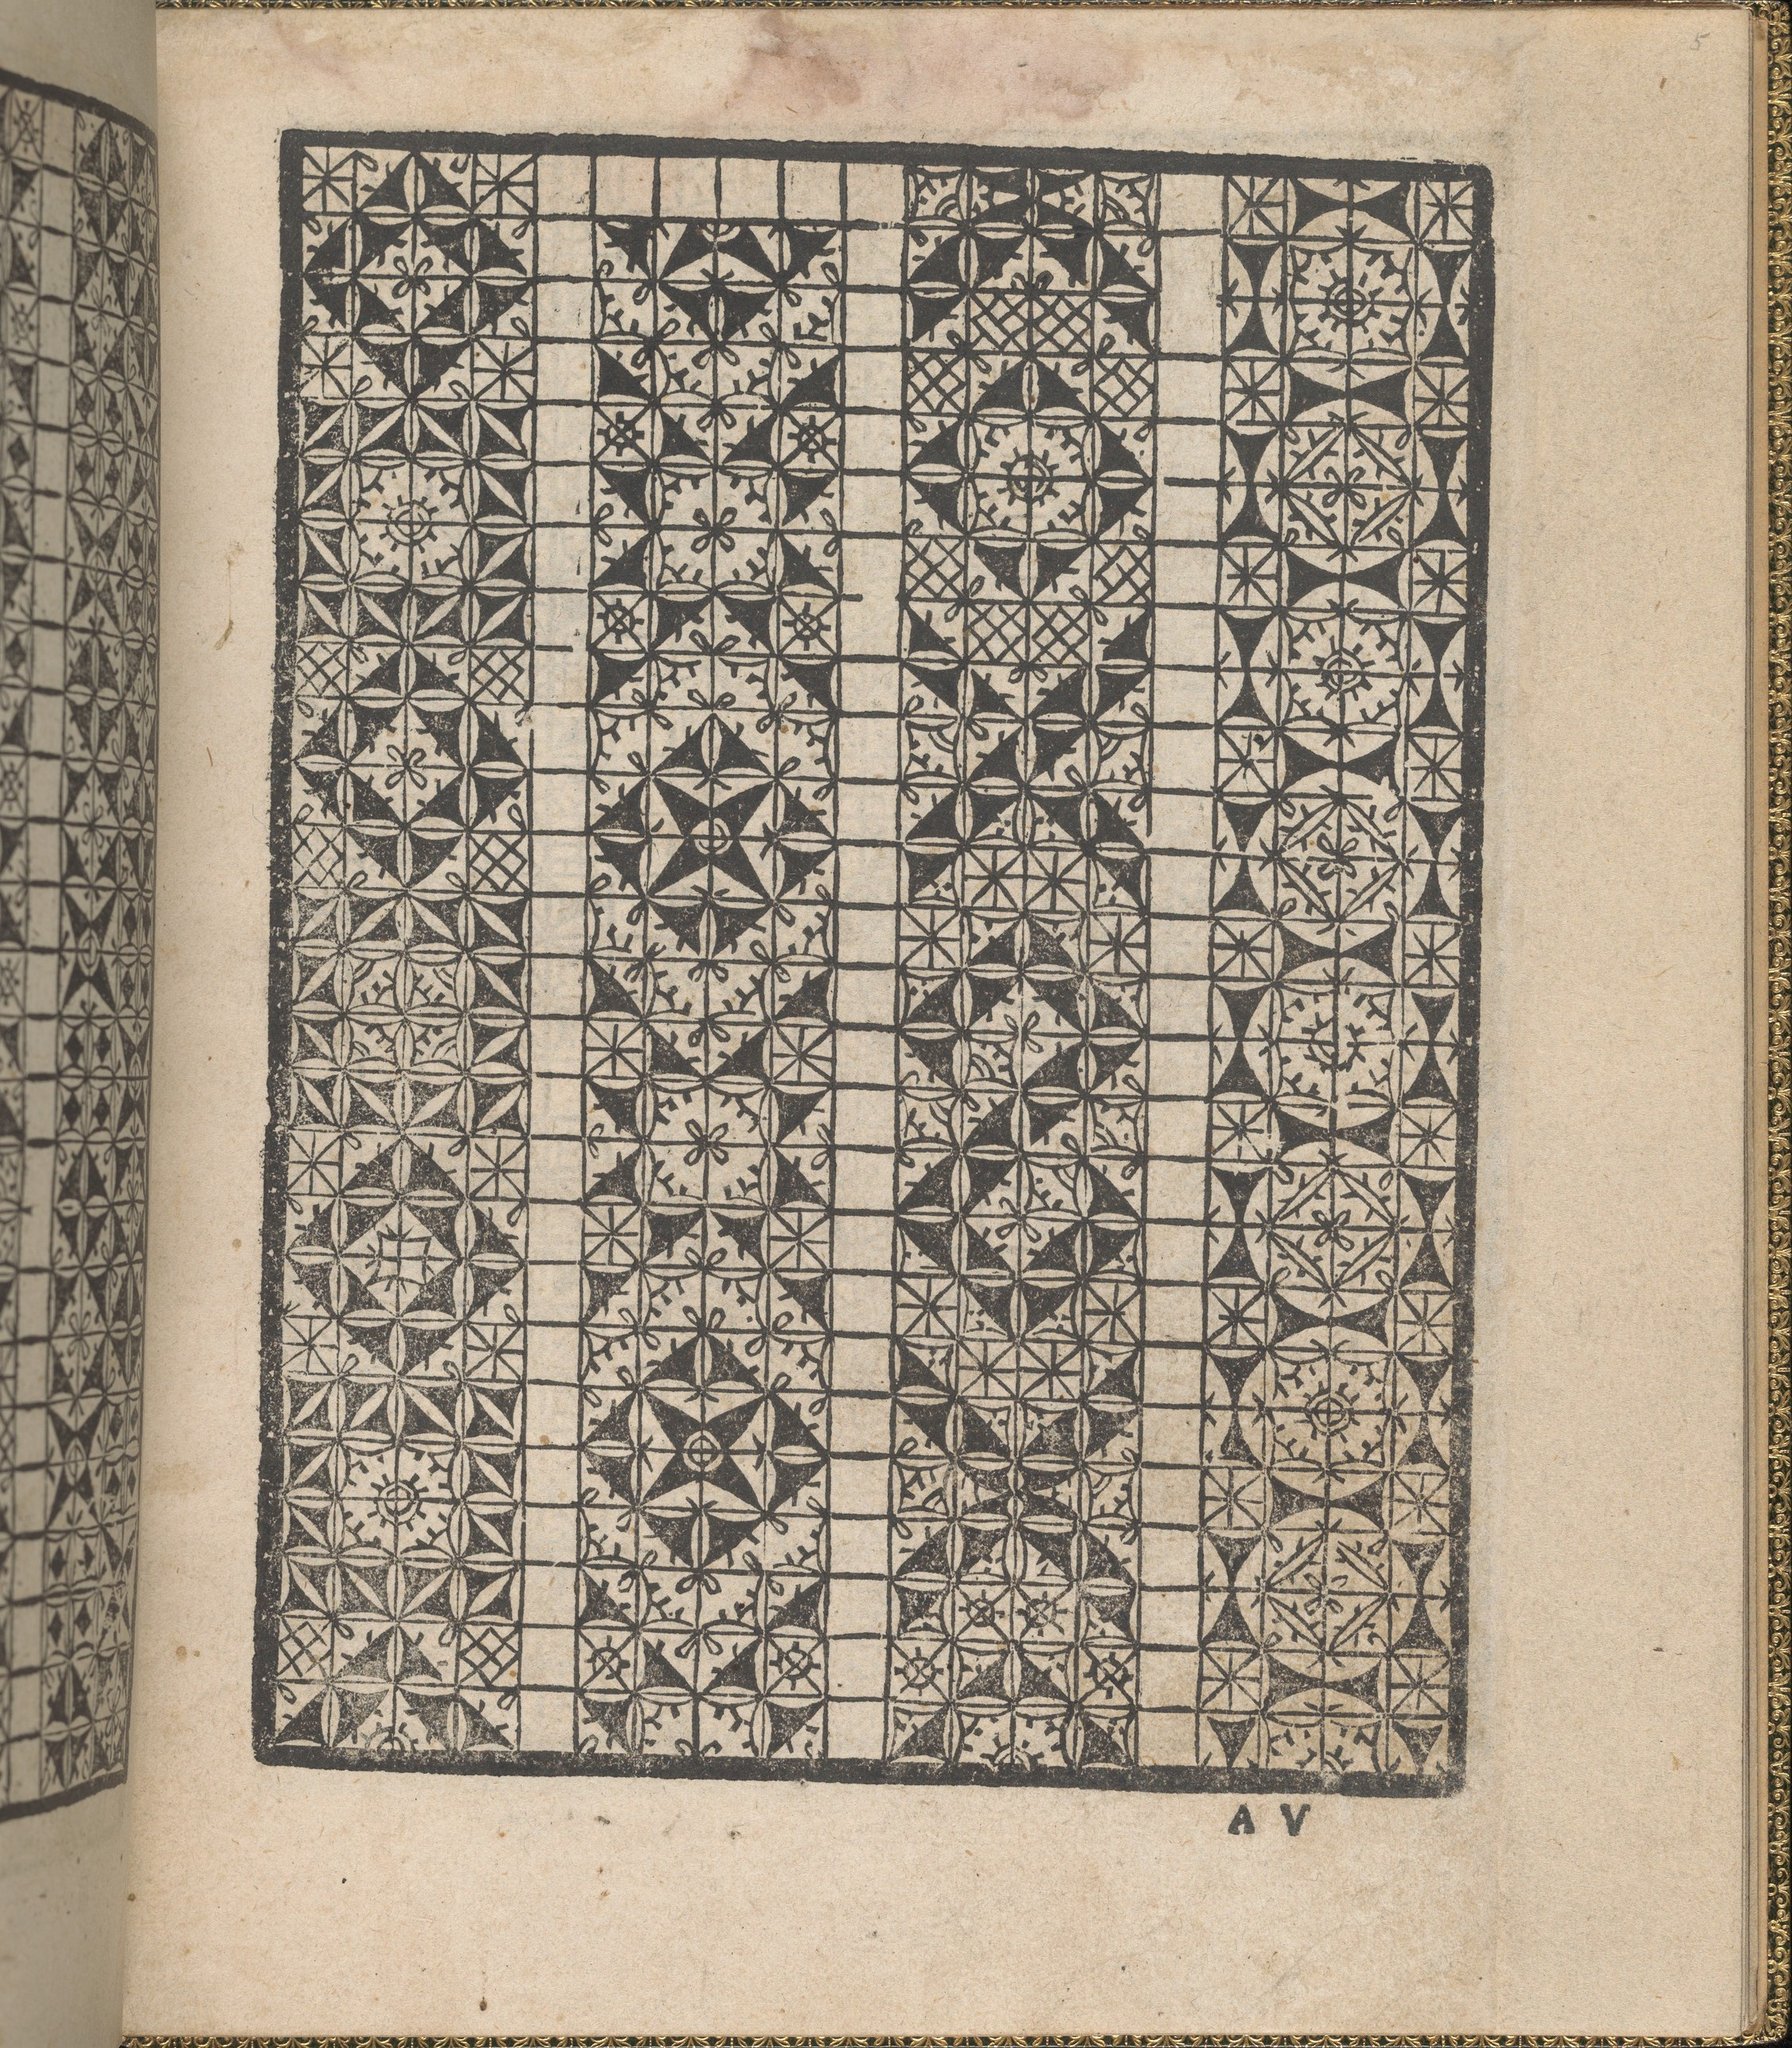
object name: book print ornament architecture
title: Giardineto novo di punti tagliati et gropposi per exercitio & ornamento delle donne (Venice 1554), page 3 (verso)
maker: matteo pagano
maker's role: publisher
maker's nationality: italian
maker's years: 1515-1588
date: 1554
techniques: woodcut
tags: ornament